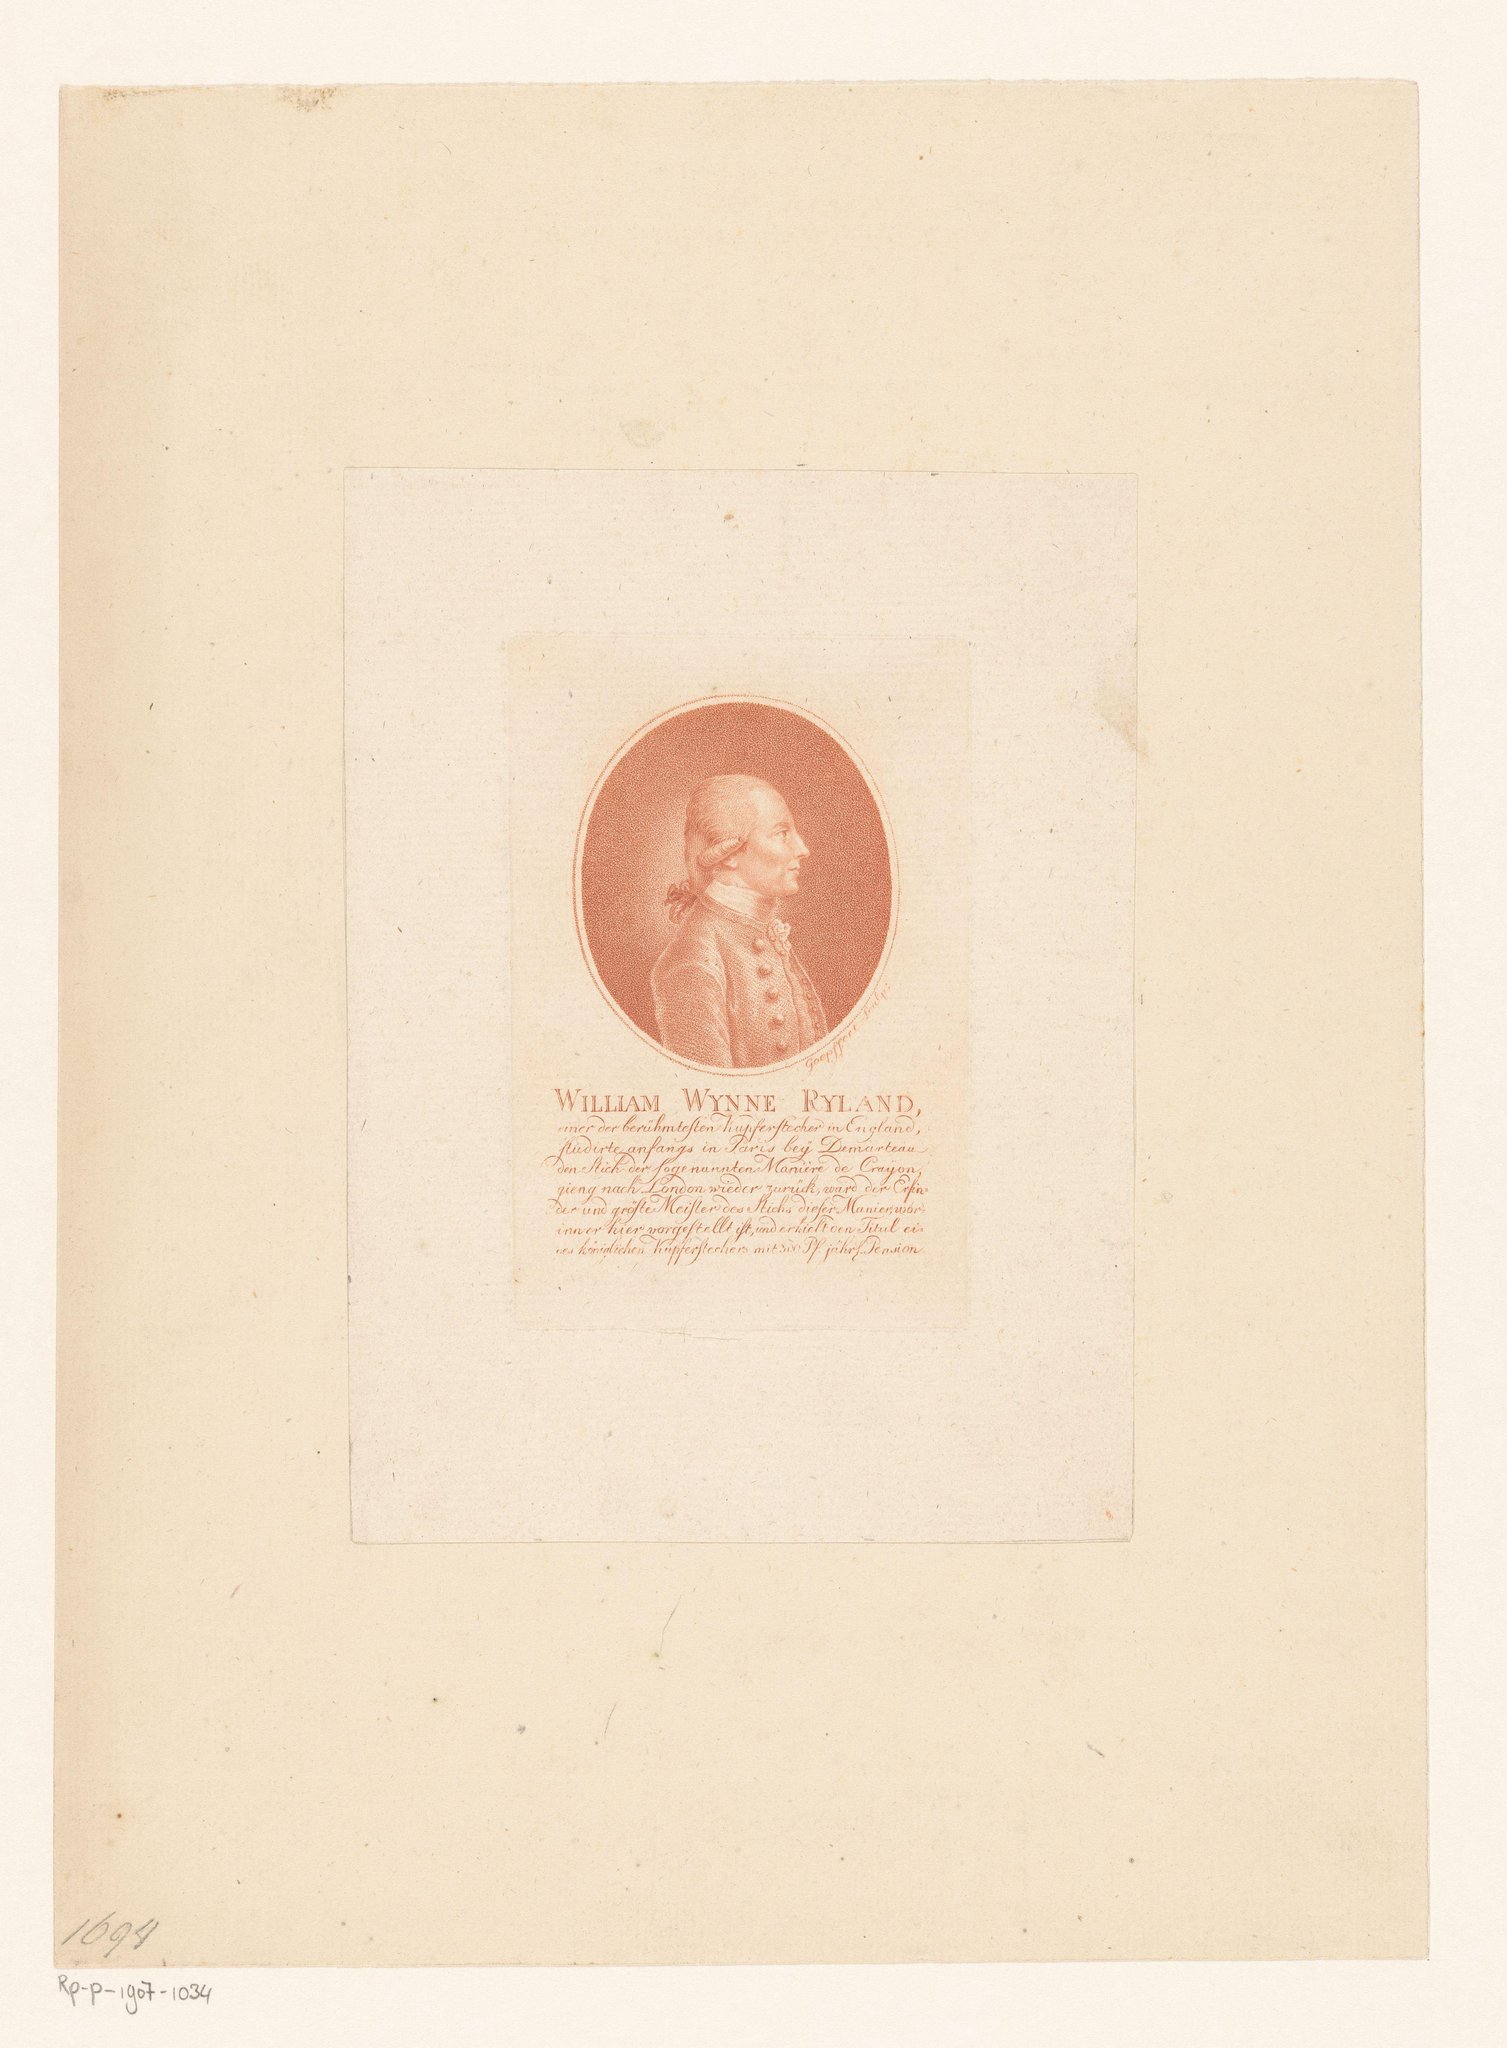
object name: print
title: Portret van William Wynne Ryland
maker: karl goepfert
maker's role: print maker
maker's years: 1760-1788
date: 1770-1783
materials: paper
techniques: roulette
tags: london, print maker, historical persons, portrait, self-portrait of graphic artist